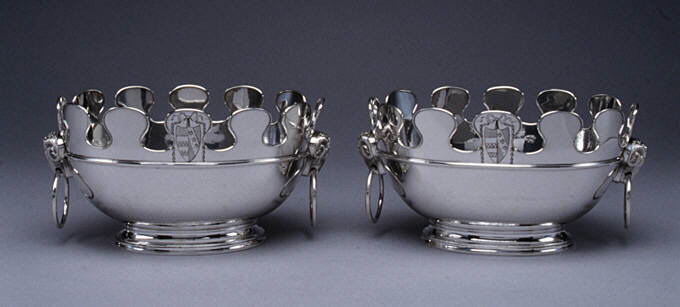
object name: verrières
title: Pair of verrières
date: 1775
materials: metal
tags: coat of arms